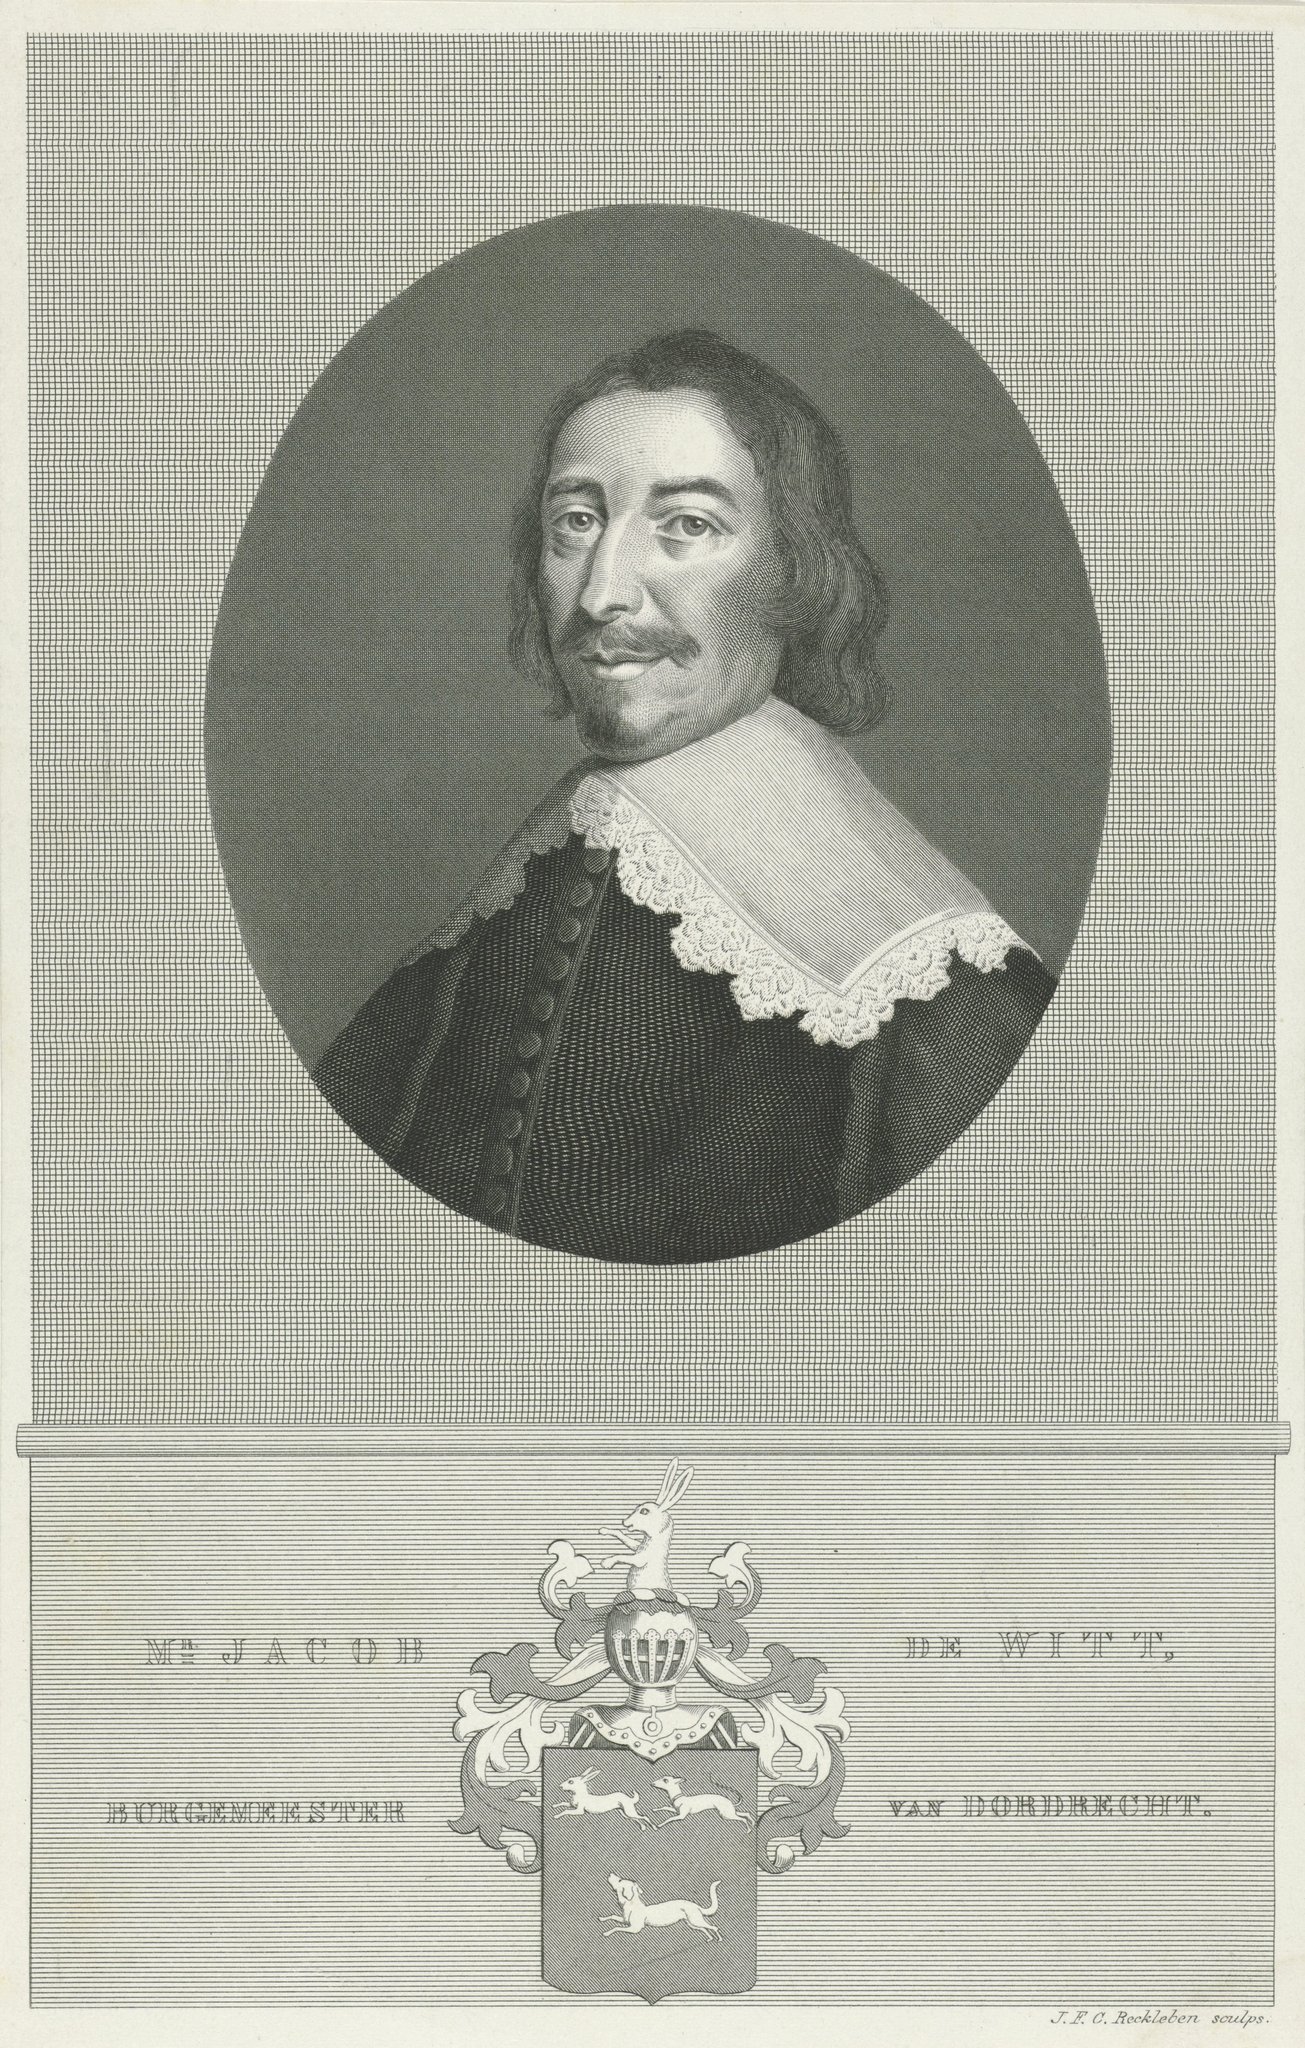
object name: print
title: Portret van Jacob de Witt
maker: jan frederik christiaan reckleben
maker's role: print maker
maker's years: 1819-1879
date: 1877-1879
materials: paper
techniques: engraving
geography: amsterdam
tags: dordrecht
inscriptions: collector's mark: Lugt 2228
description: Illustratie in: Arend, Johannes Pieter. Algemeene geschiedenis des vaderlands van de vroegste tijden tot op heden. 5 delen, Amsterdam: Schleijer, J.F. 1840-1884, dl. 4.1, p. 129.